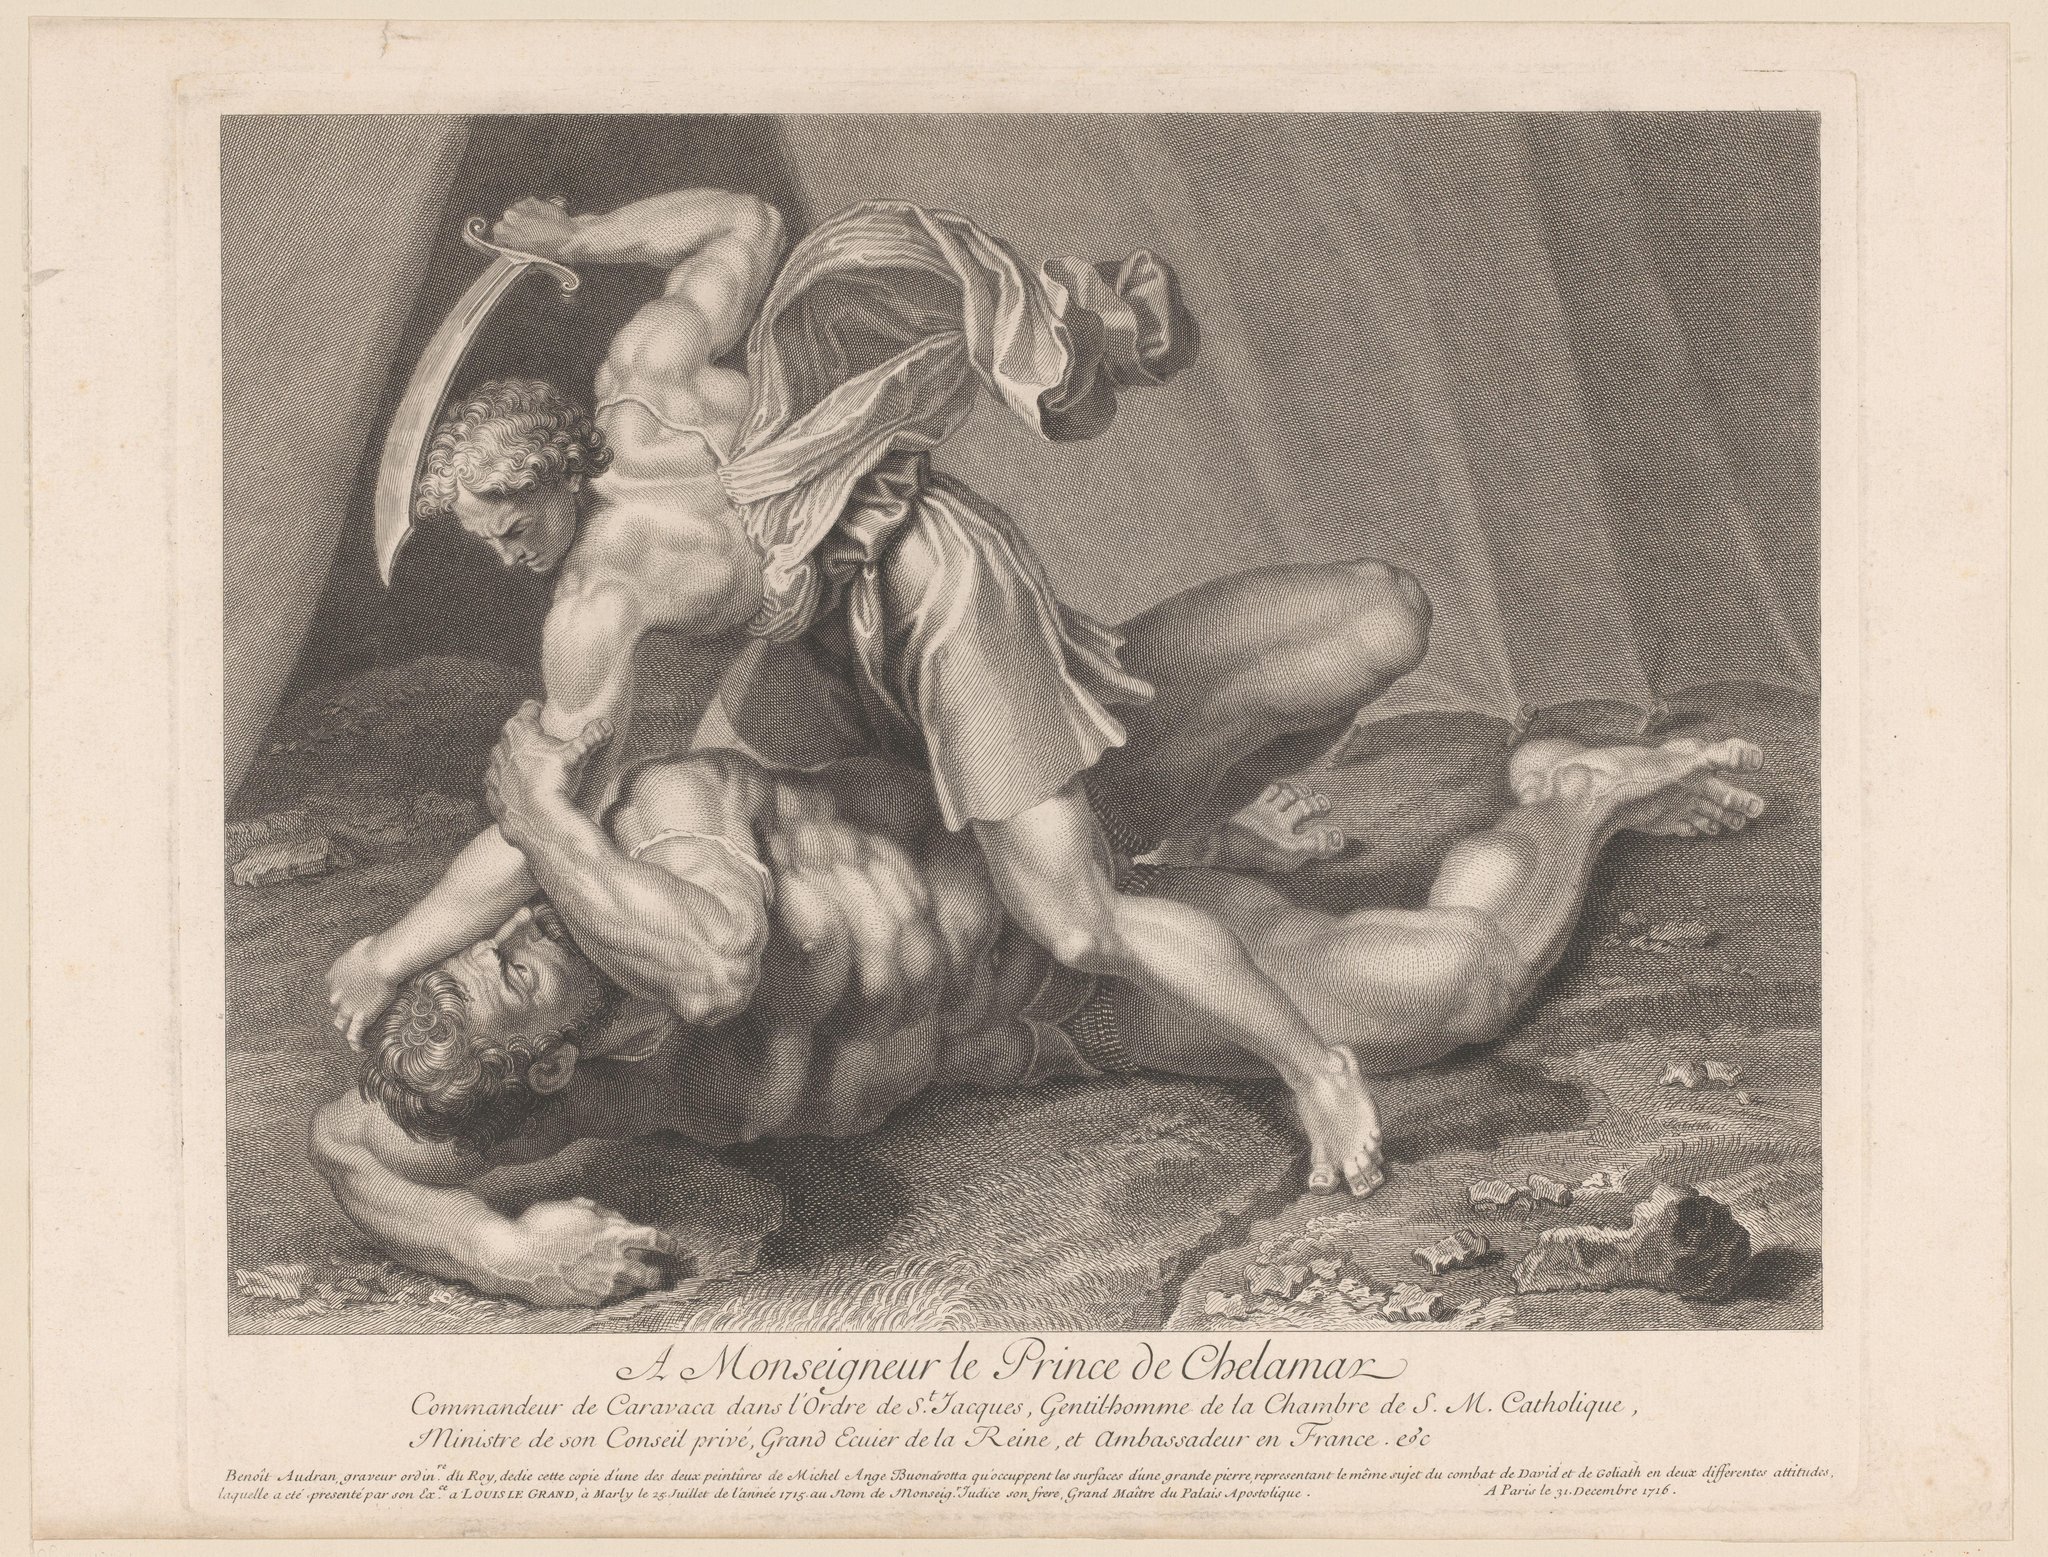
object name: print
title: David onthoofdt Goliath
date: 1716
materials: paper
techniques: etching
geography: paris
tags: david fighting goliath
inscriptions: collector's mark: Lugt 240